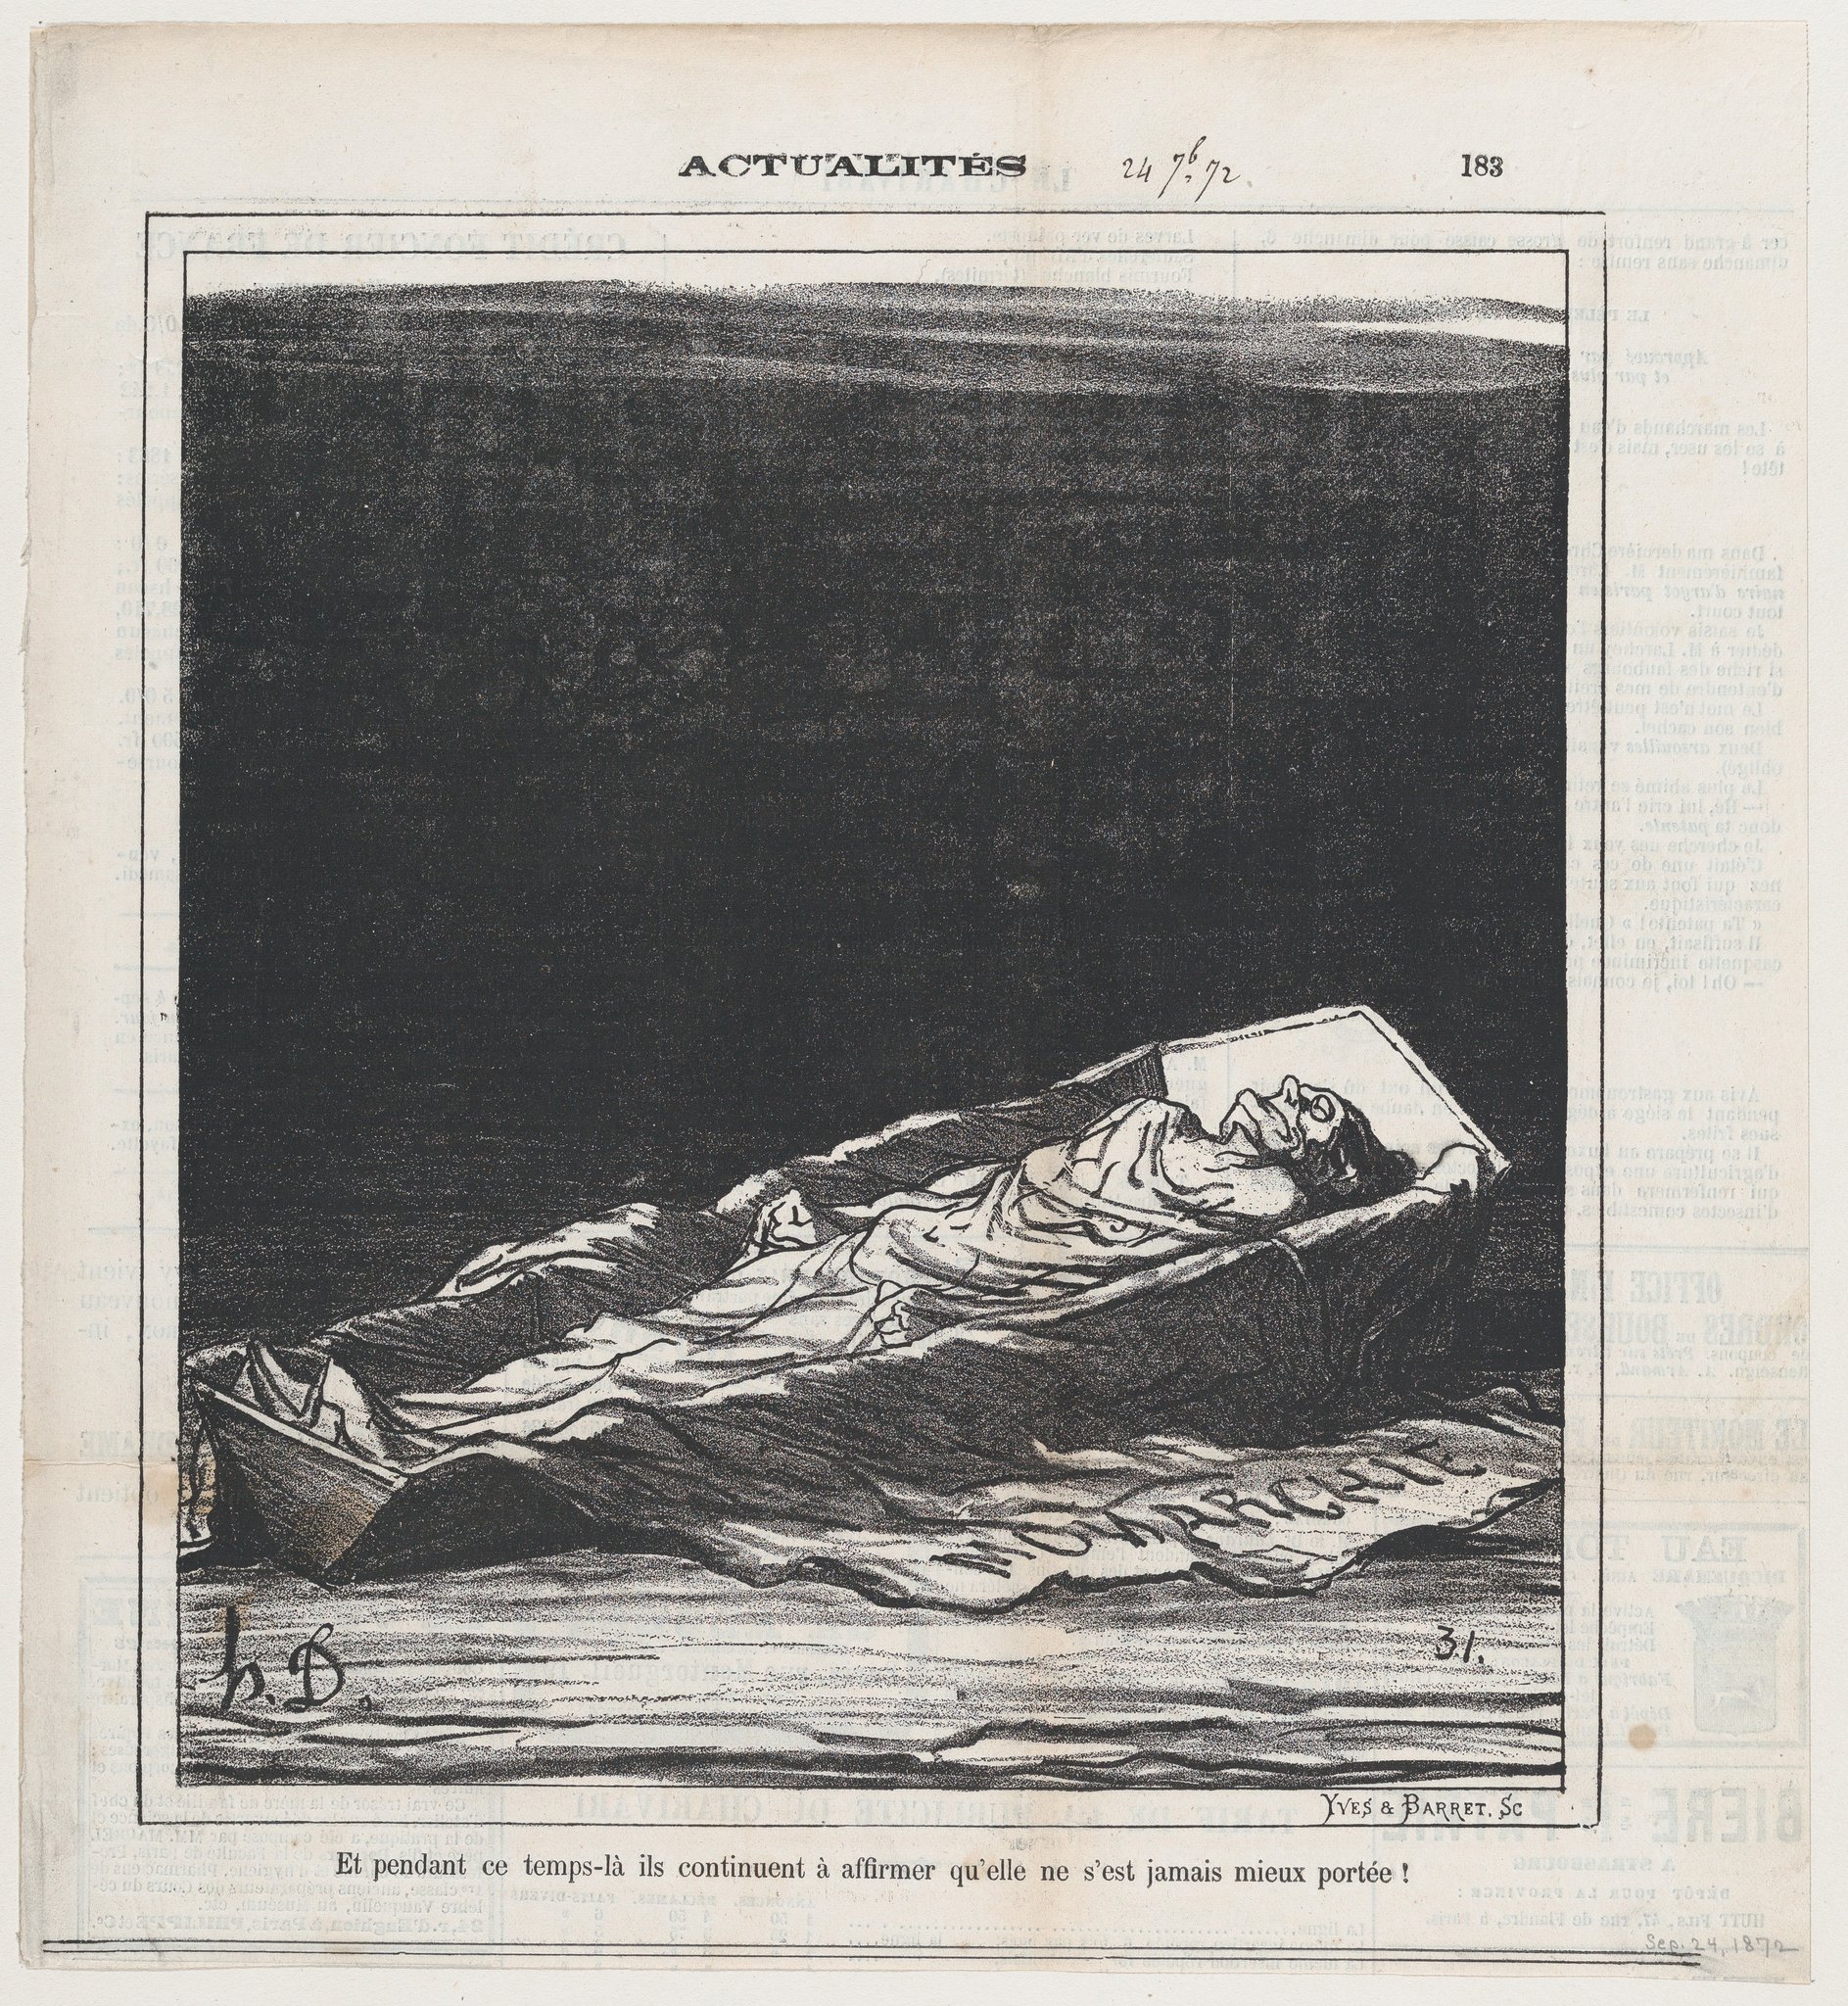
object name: print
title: Meanwhile they keep on insisting that she has never been better!, from 'News of the day,' published in Le Charivari, September 24, 1872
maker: honoré daumier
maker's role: artist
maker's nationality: french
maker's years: 1808-1879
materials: paper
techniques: lithograph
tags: corpses,men,death